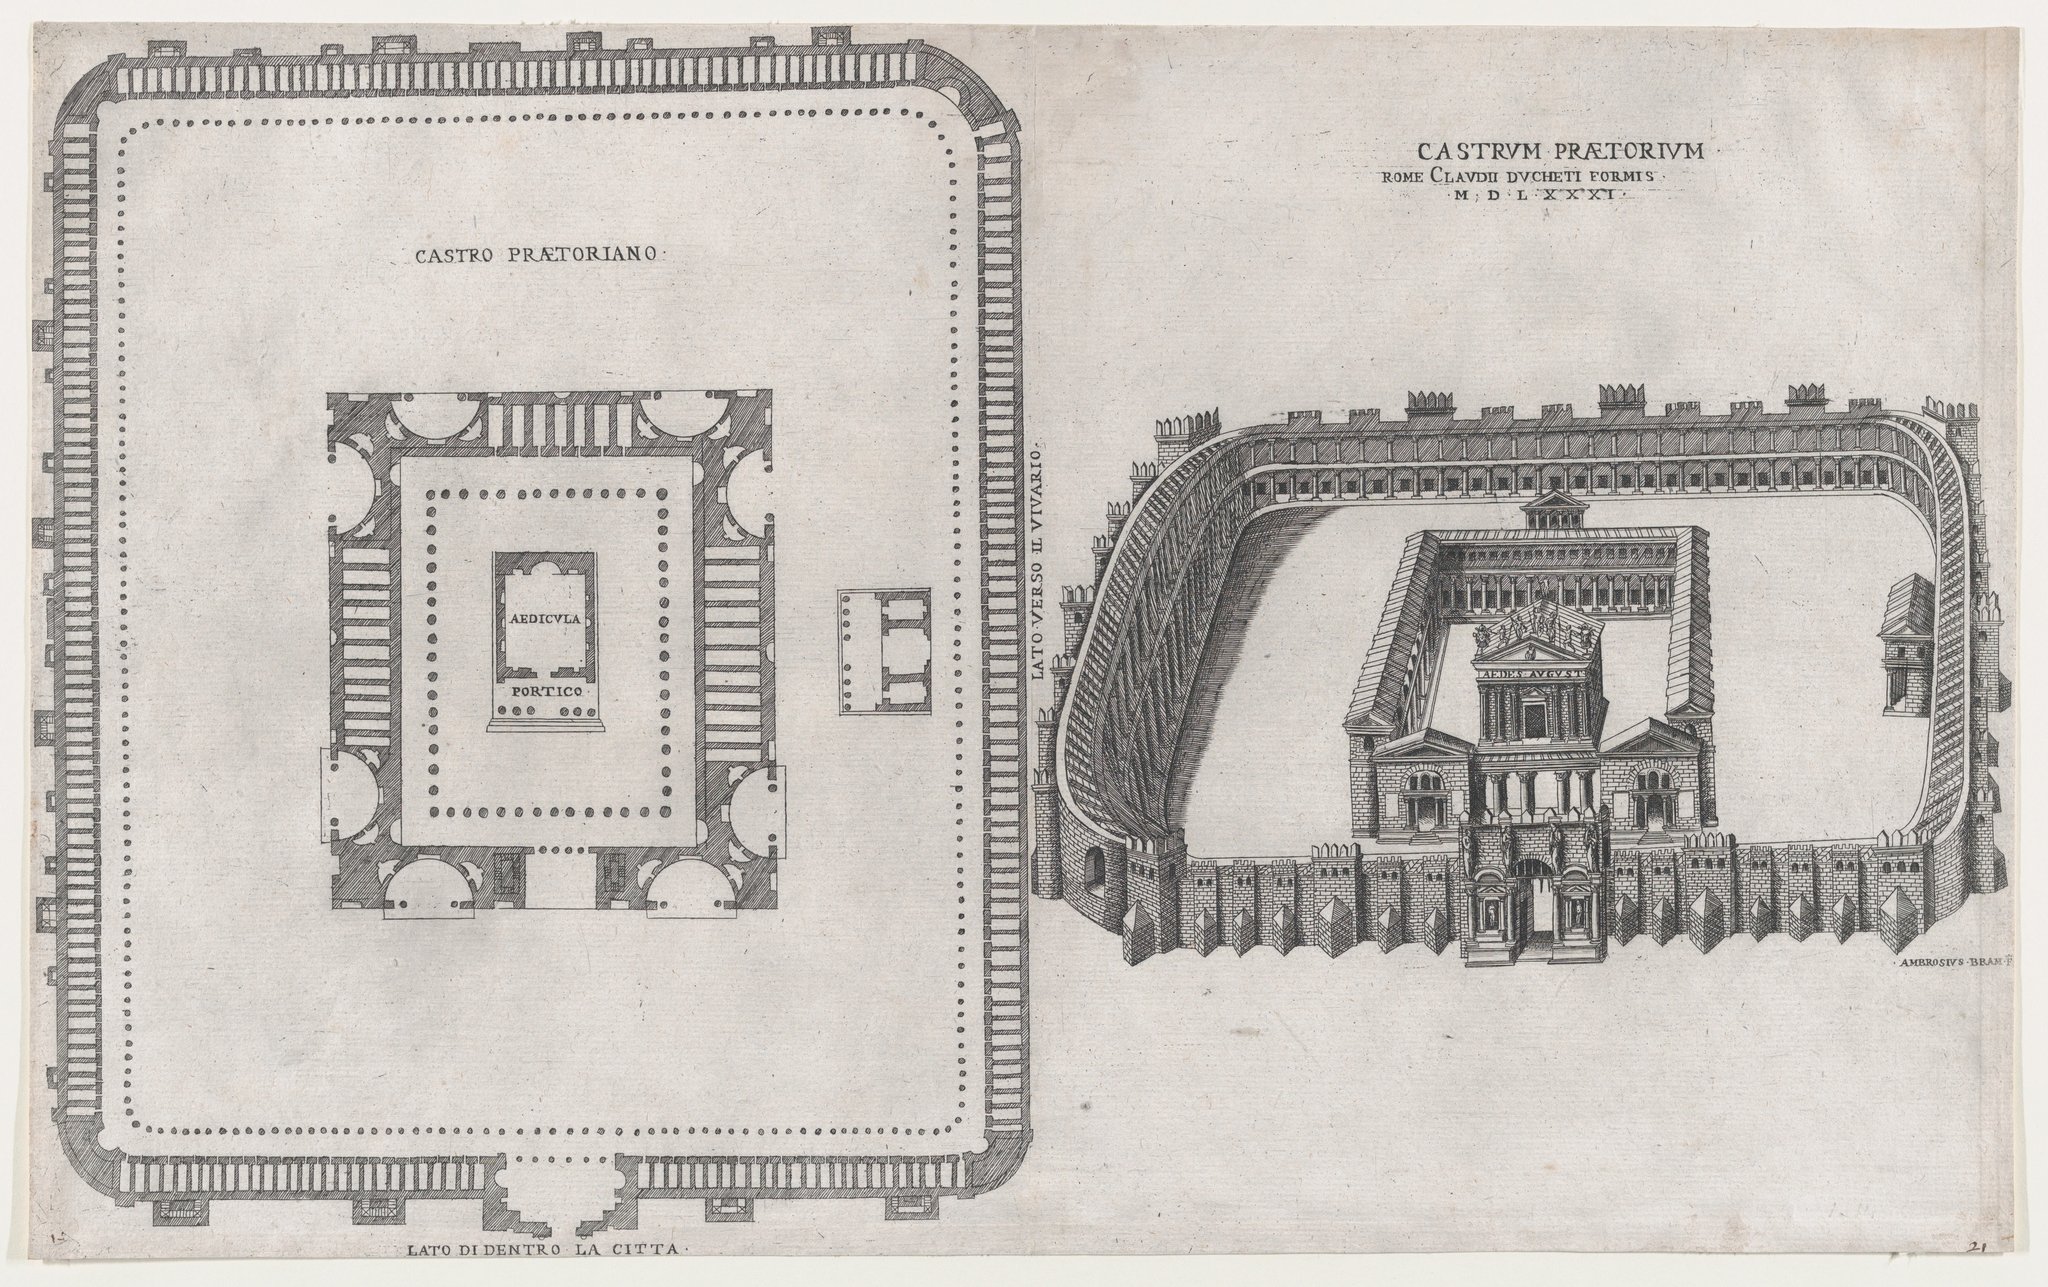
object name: print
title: Castrum, from "Speculum Romanae Magnificentiae"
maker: giovanni ambrogio brambilla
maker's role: artist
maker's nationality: italian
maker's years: 1575-1599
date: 1581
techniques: engraving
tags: architecture,fortification,rome